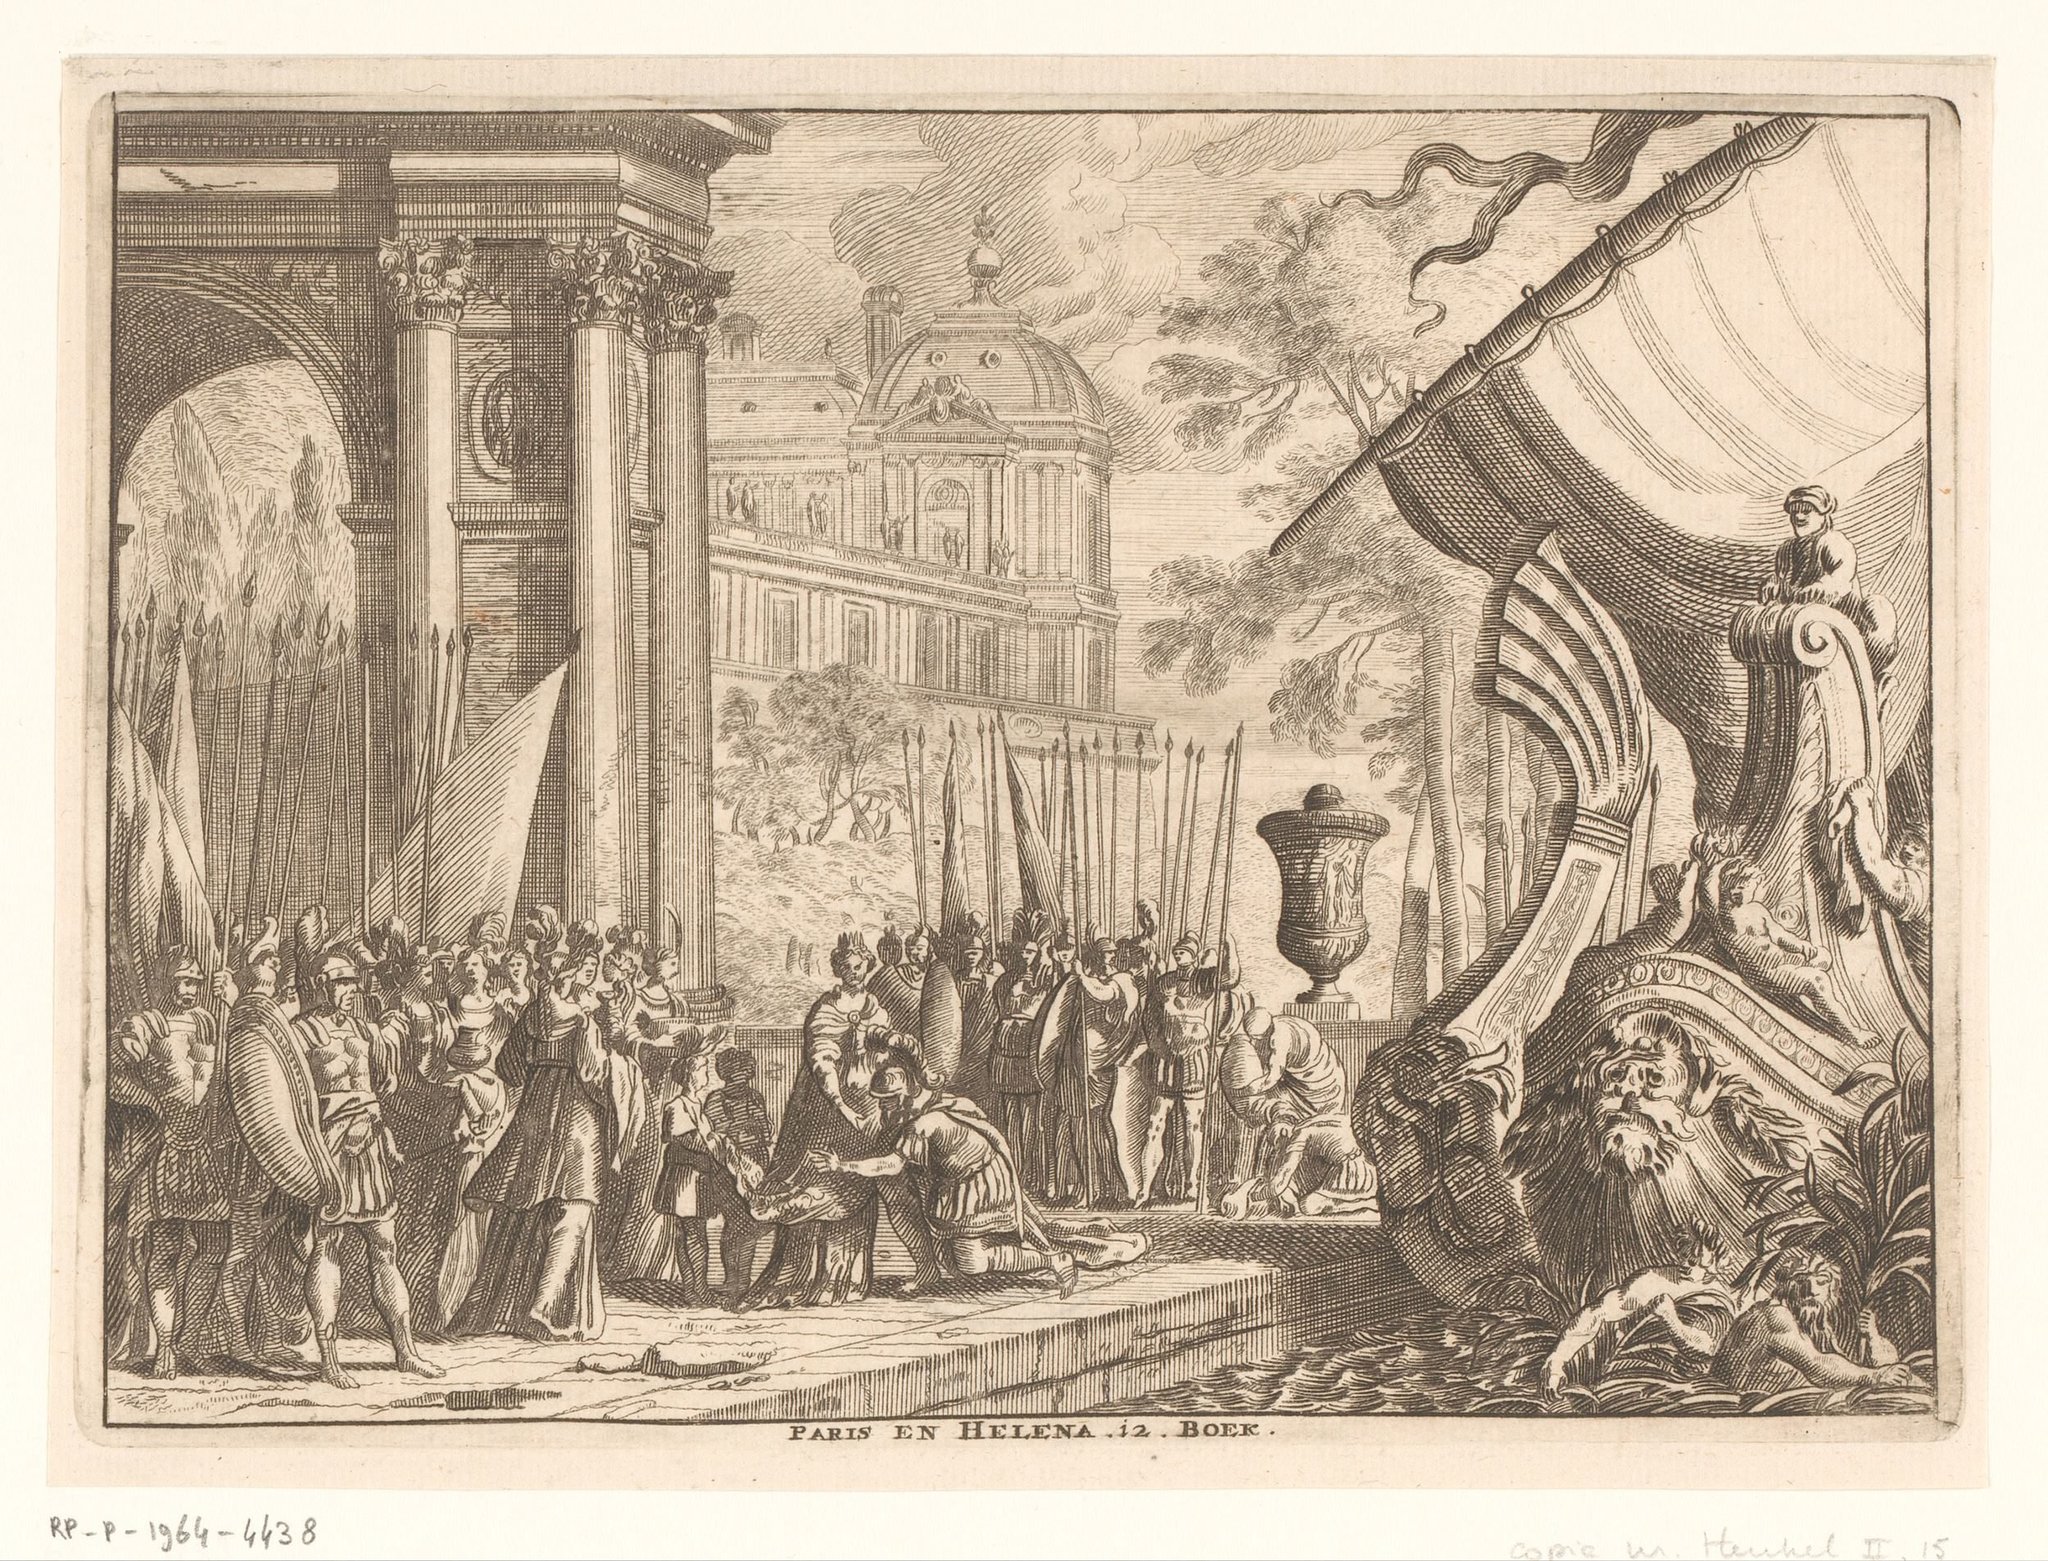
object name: print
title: Paris en Helena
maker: Anonymous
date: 1628-1682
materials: paper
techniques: etching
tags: the meeting of aeneas and dido; when he approaches her throne, the cloud enveloping him and achates vanishes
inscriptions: collector's mark: Lugt 2228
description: Lijkt deel uit te maken van een serie prenten met mythologische onderwerpen, naar prenten door Jean Lepautre en voorzien van Nederlandse titels. Mogelijk werd de serie uitgegeven door Cornelis (I) of Cornelis (II) Danckerts, zoals vermeld op RP-P-1964-4431 en RP-P-1964-4443.